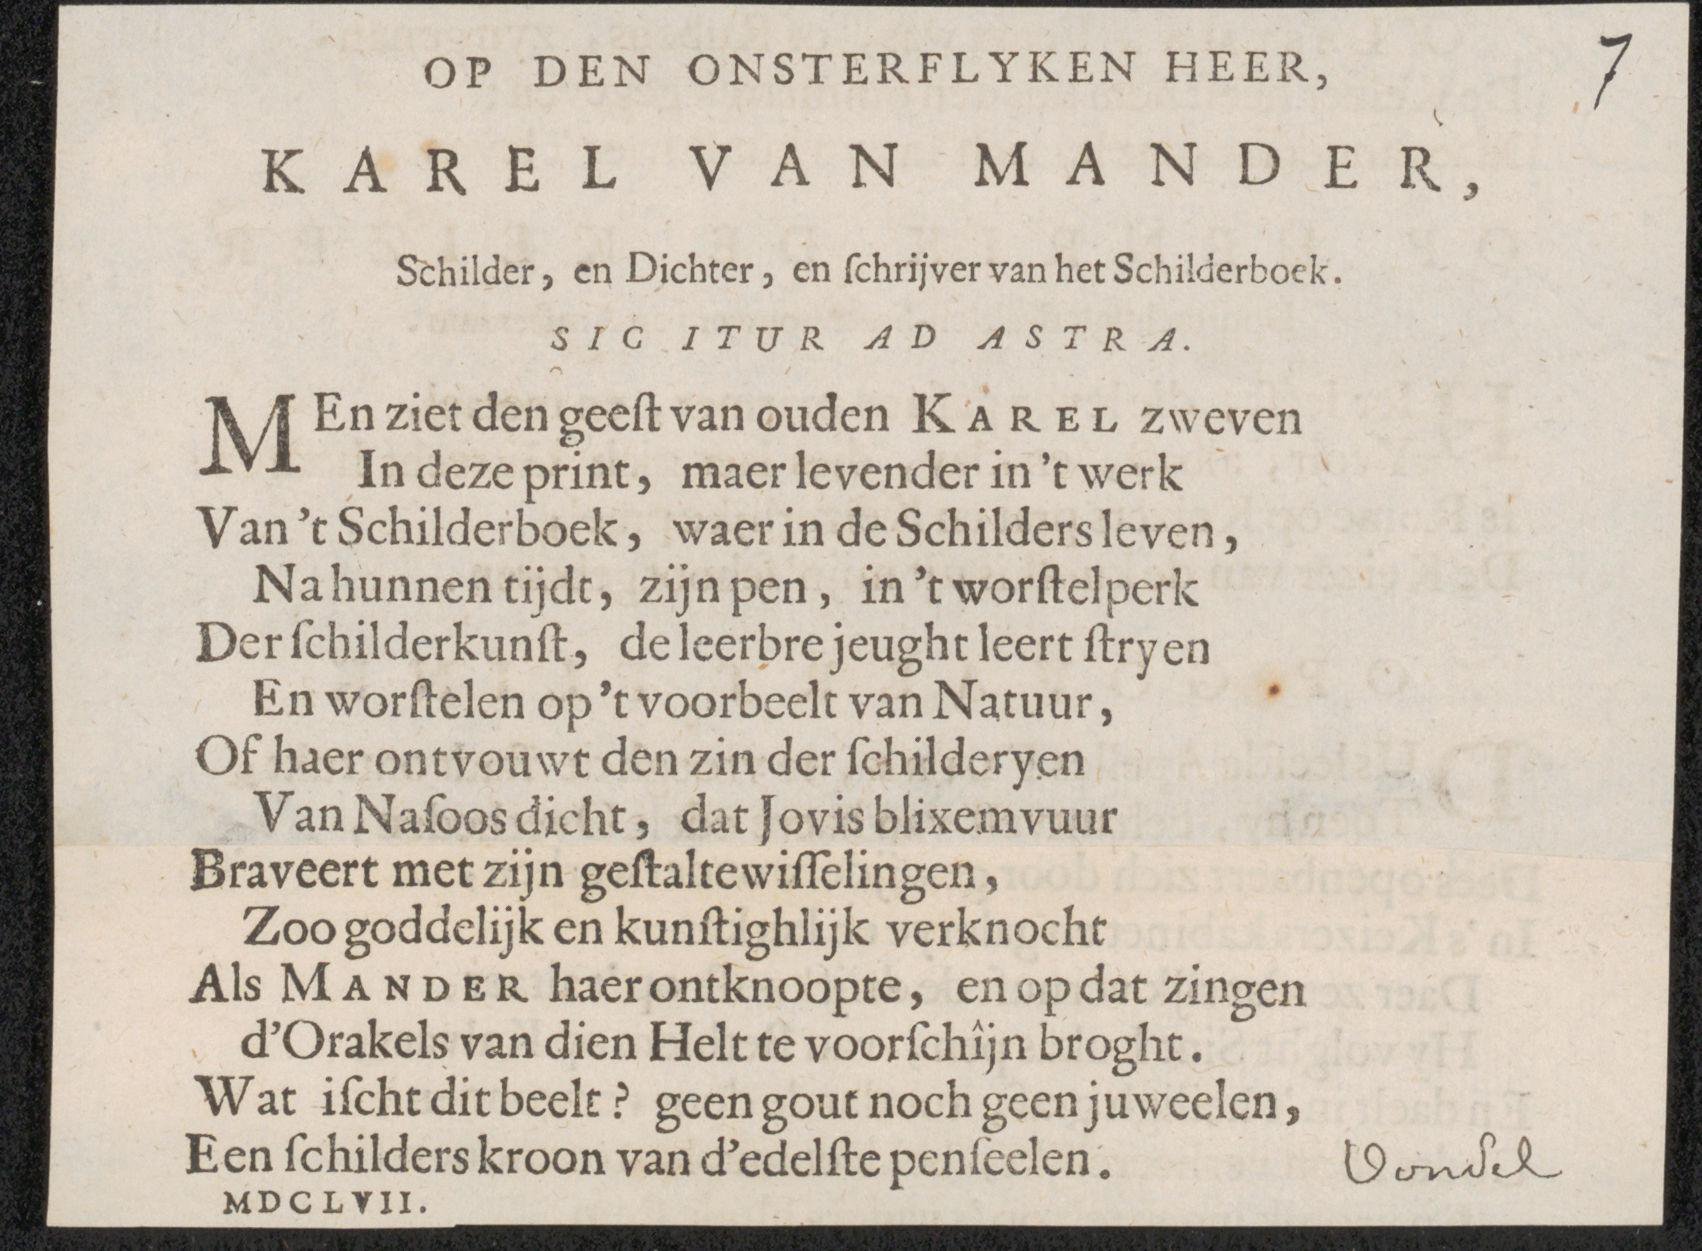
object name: poem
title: Gedicht op Karel van Mander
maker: joost van den vondel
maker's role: dichter, toneelschrijver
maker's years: 1587-1679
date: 1657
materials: paper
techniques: printing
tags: painter, print maker, draughtsman, karel van mander (i)